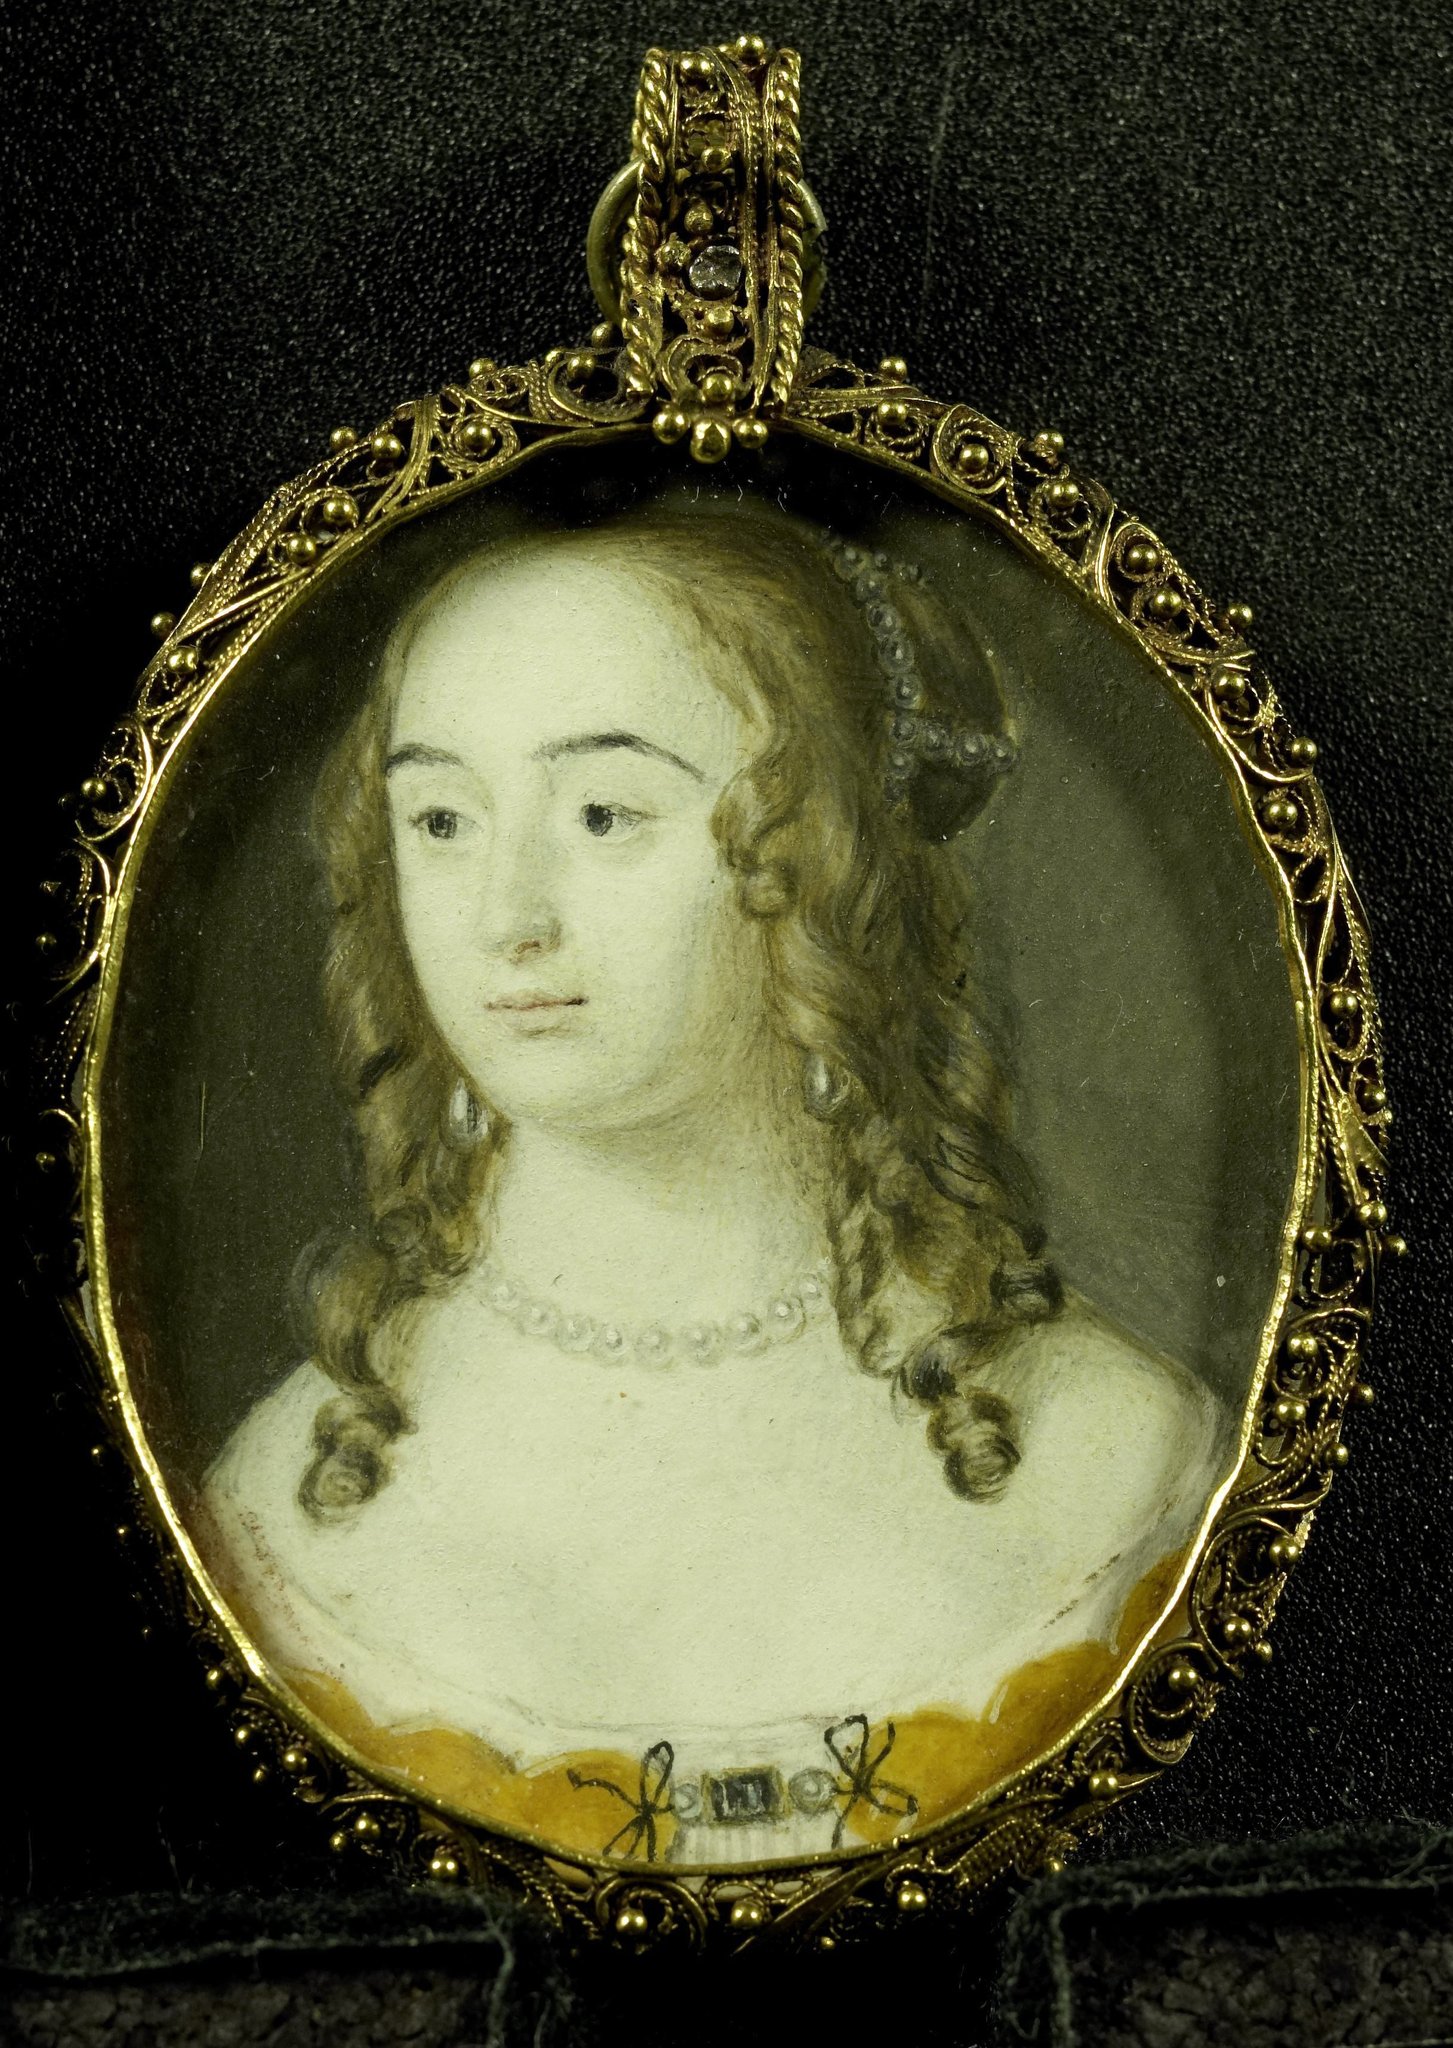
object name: painting, miniature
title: Portrait of Henriette Marie (1626-51), Countess Palatine. Daughter of Frederik V, King of Bohemia, called the 'Winter King'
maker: alexander cooper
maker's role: draughtsman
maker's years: 1609-1660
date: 1640-1650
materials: cardboard, glass, gold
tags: henriëtte maria van de palts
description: Portret van Henriette Marie (1626-51) van de Paltz, dochter van Frederik V, koning van Bohemen, bijgenaamd de 'Winterkoning'. Buste, naar links. Naar het portret door Honthorst in de National Gallery te Londen. Vroeger onjuist geïdentificeerd als Albertina Agnes, gravin van Nassau. Onderdeel van de collectie portretminiaturen.